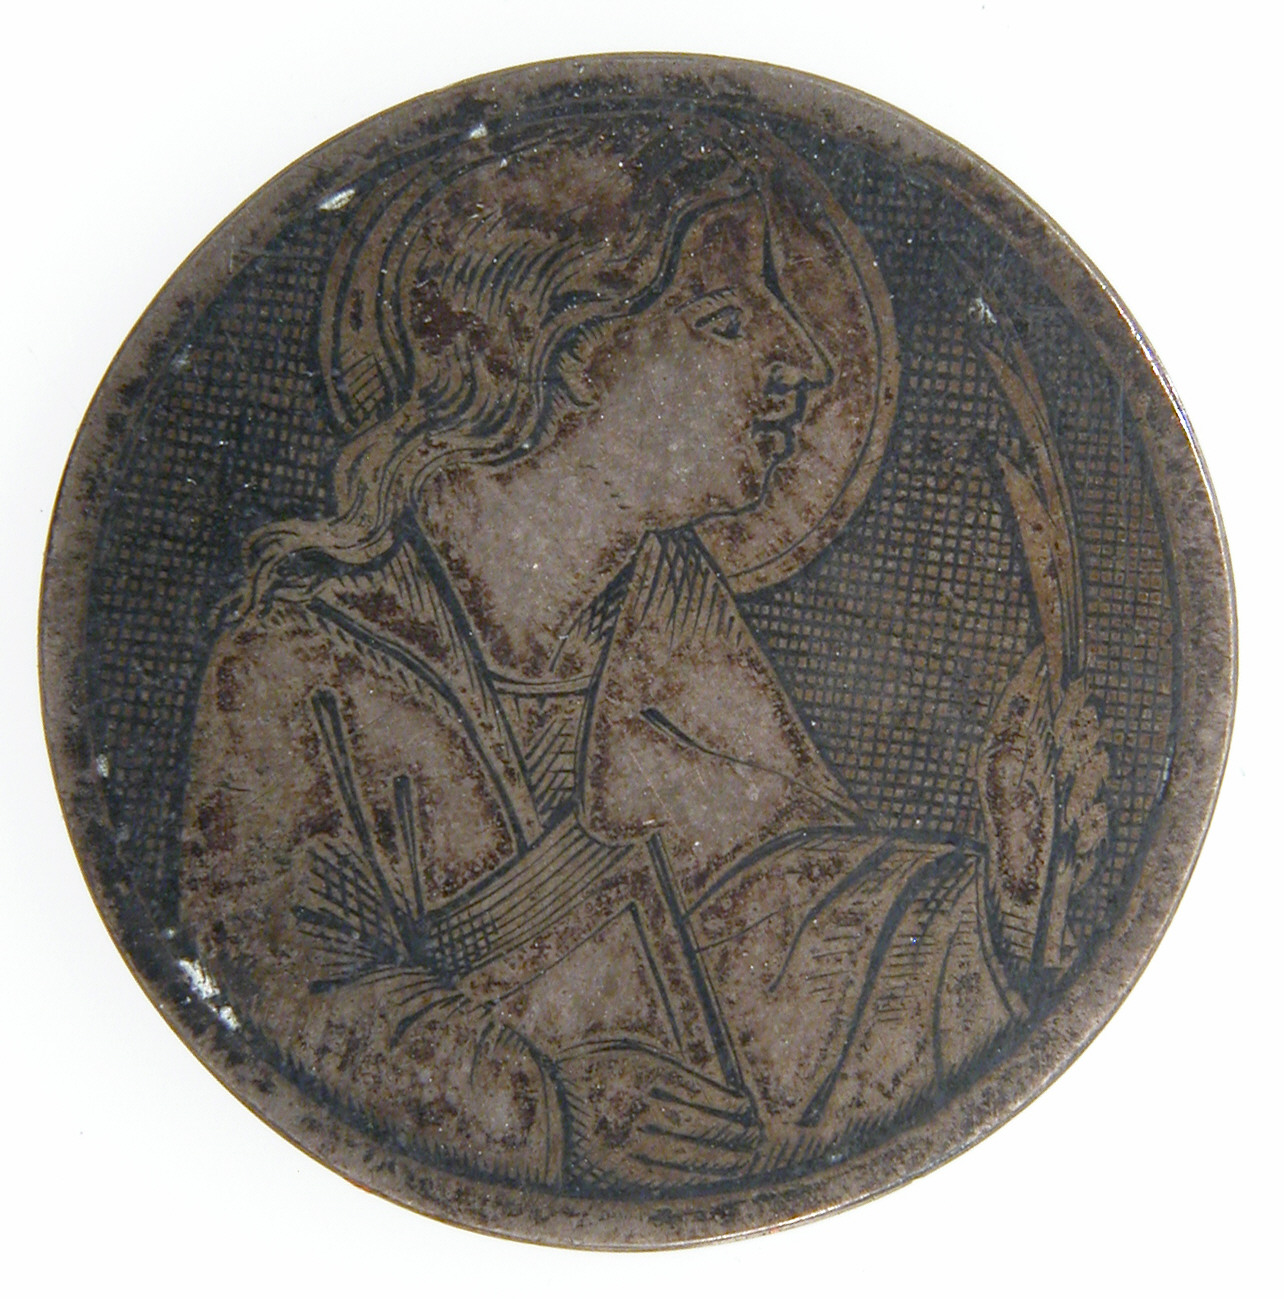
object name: plaque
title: Plaquette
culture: italian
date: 1401-1500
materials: niello, silver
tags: men